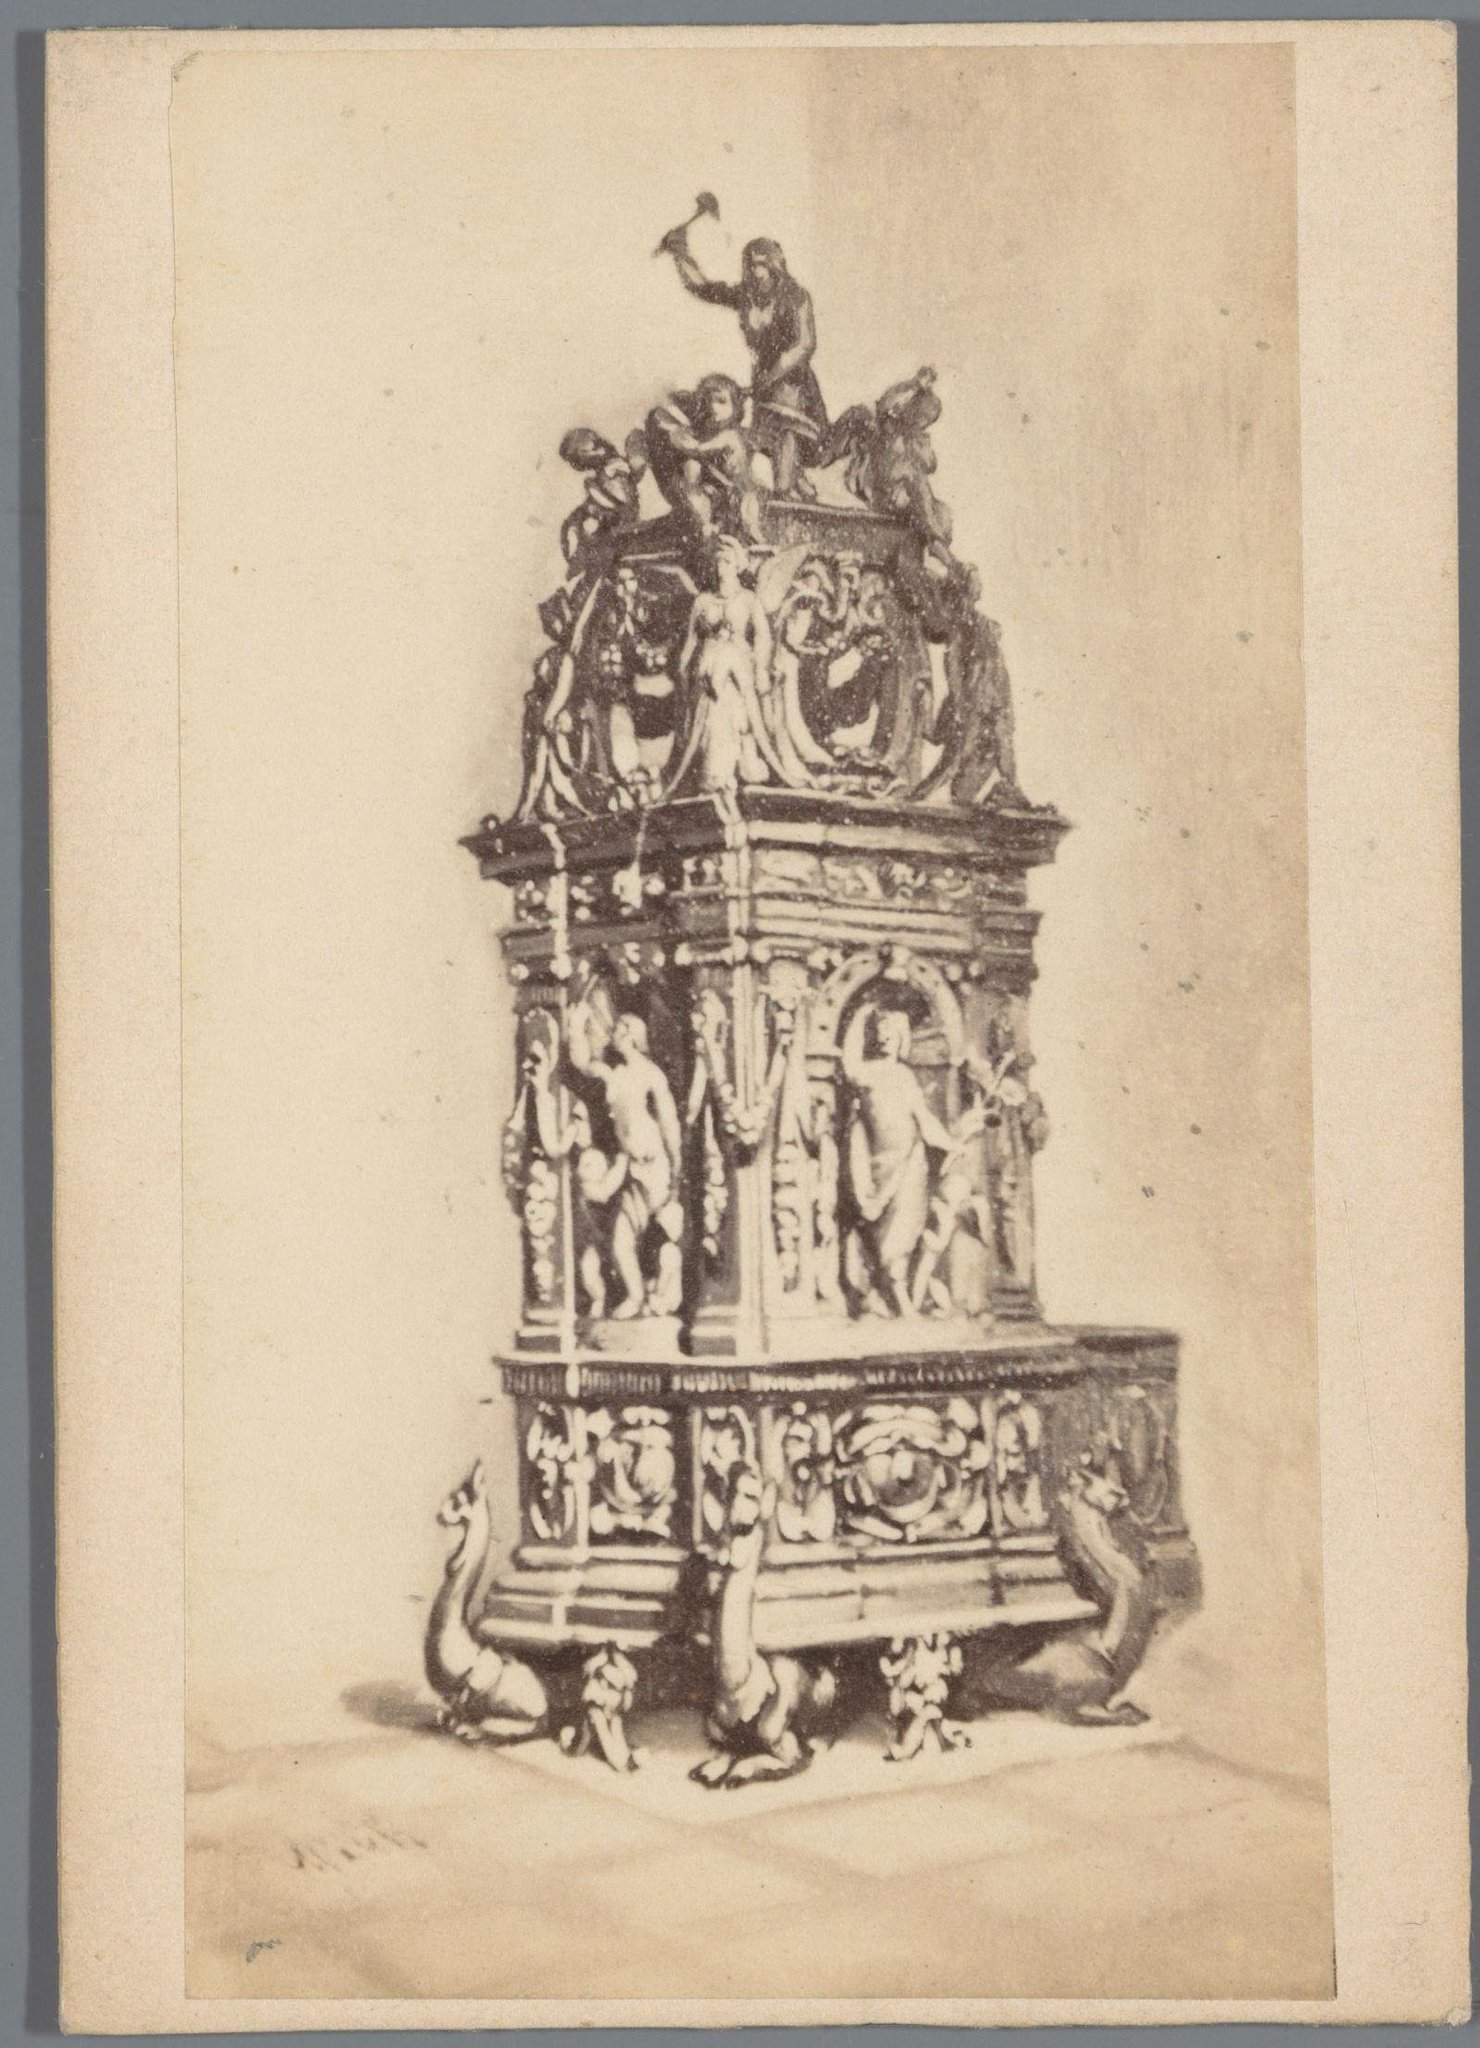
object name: reproduction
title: Fotoreproductie van een prent waarop een reliekhouder is afgebeeld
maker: ferdinand brauer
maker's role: publisher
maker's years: -1915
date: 1855-1885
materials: cardboard, paper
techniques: albumen print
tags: relics (and reliquaries)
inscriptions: inscription: ‘[...]’